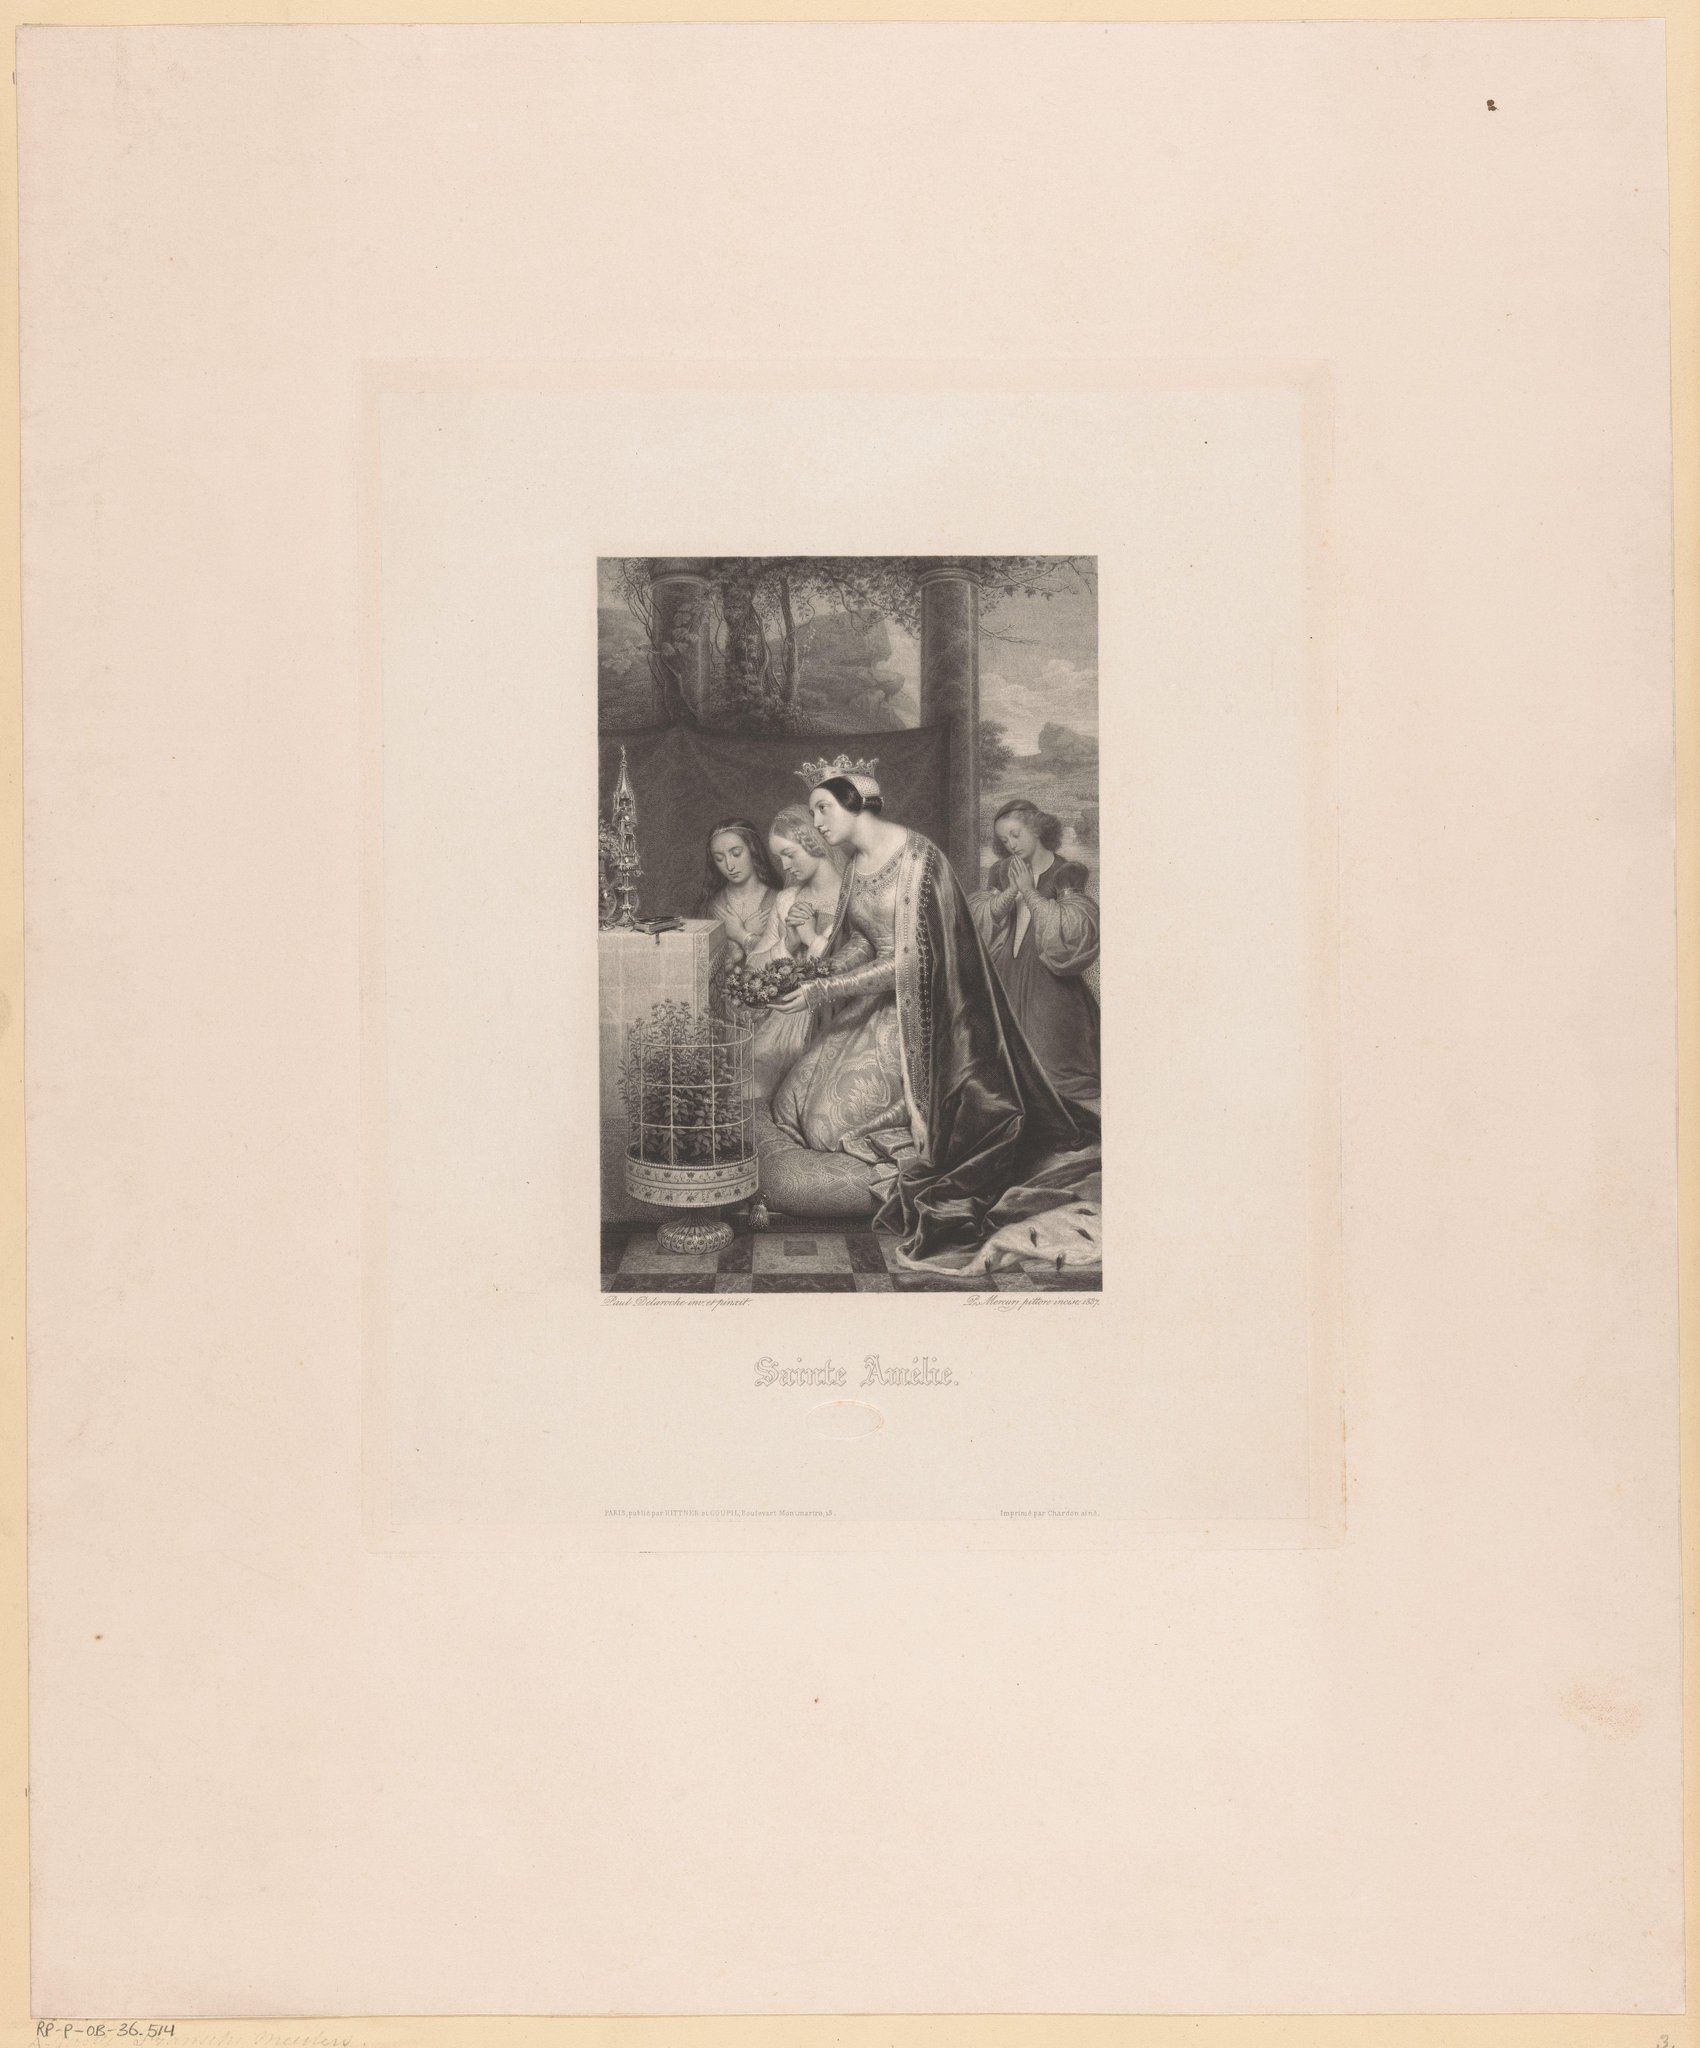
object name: print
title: De heilige Amélie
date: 1837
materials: paper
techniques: engraving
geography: paris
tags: (public) prayer, female saints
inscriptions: collector's mark: Lugt 2140, collector's mark: Lugt 12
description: De heilige Amélie zit geknield voor een altaar met bloemen in haar handen. Naast haar knielen drie jonge dames. Op de achtergrond een landschap.